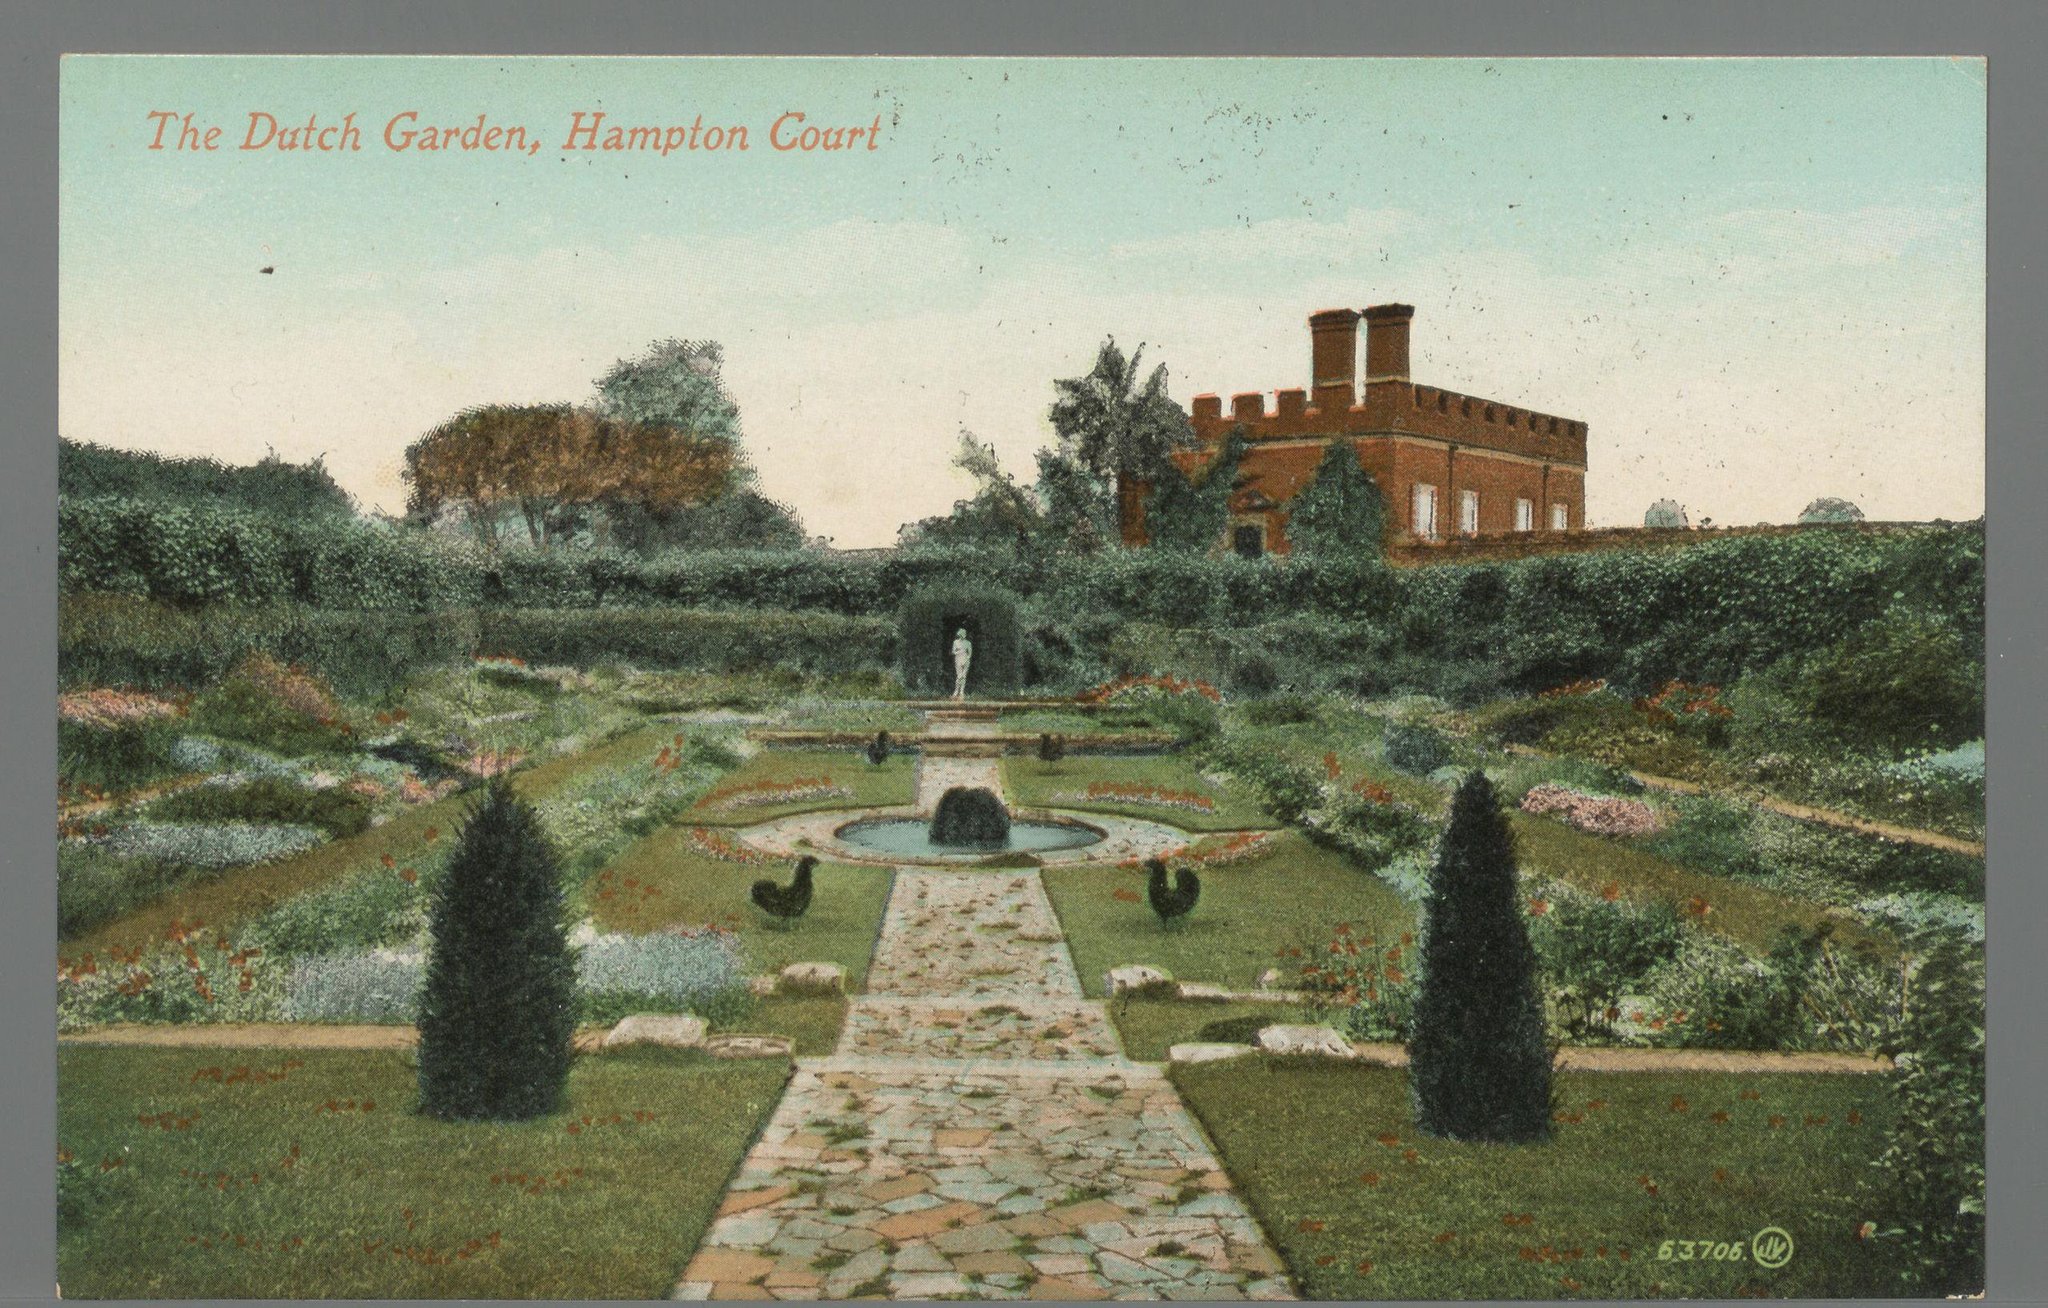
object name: ansichtkaart, prentbriefkaart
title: Valentine's Series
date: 1902-1930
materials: cardboard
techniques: lithograph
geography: great britain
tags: garden, palace